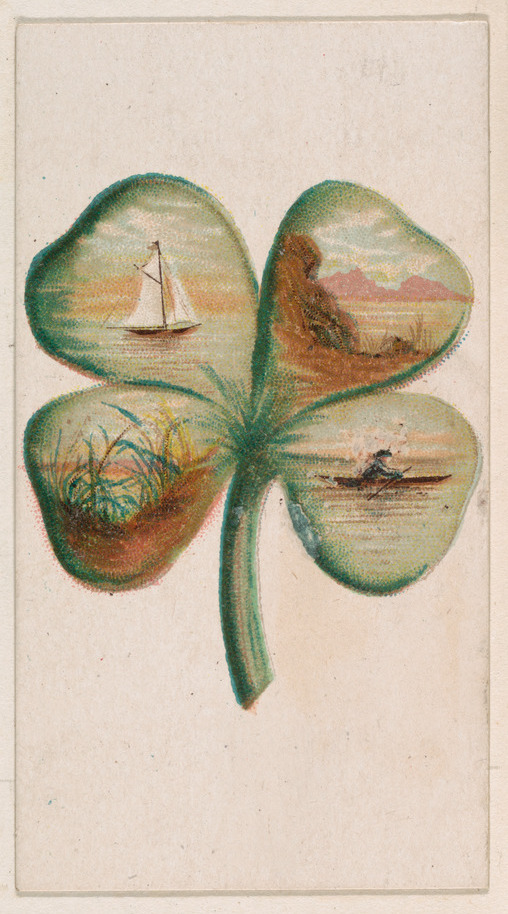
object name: print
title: Four-leaf clover, from the Novelties series (N228, Type 5) issued by Kinney Bros.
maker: kinney brothers tobacco company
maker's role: publisher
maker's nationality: american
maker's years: 1869-2011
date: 1889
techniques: color lithograph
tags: leaves,boats